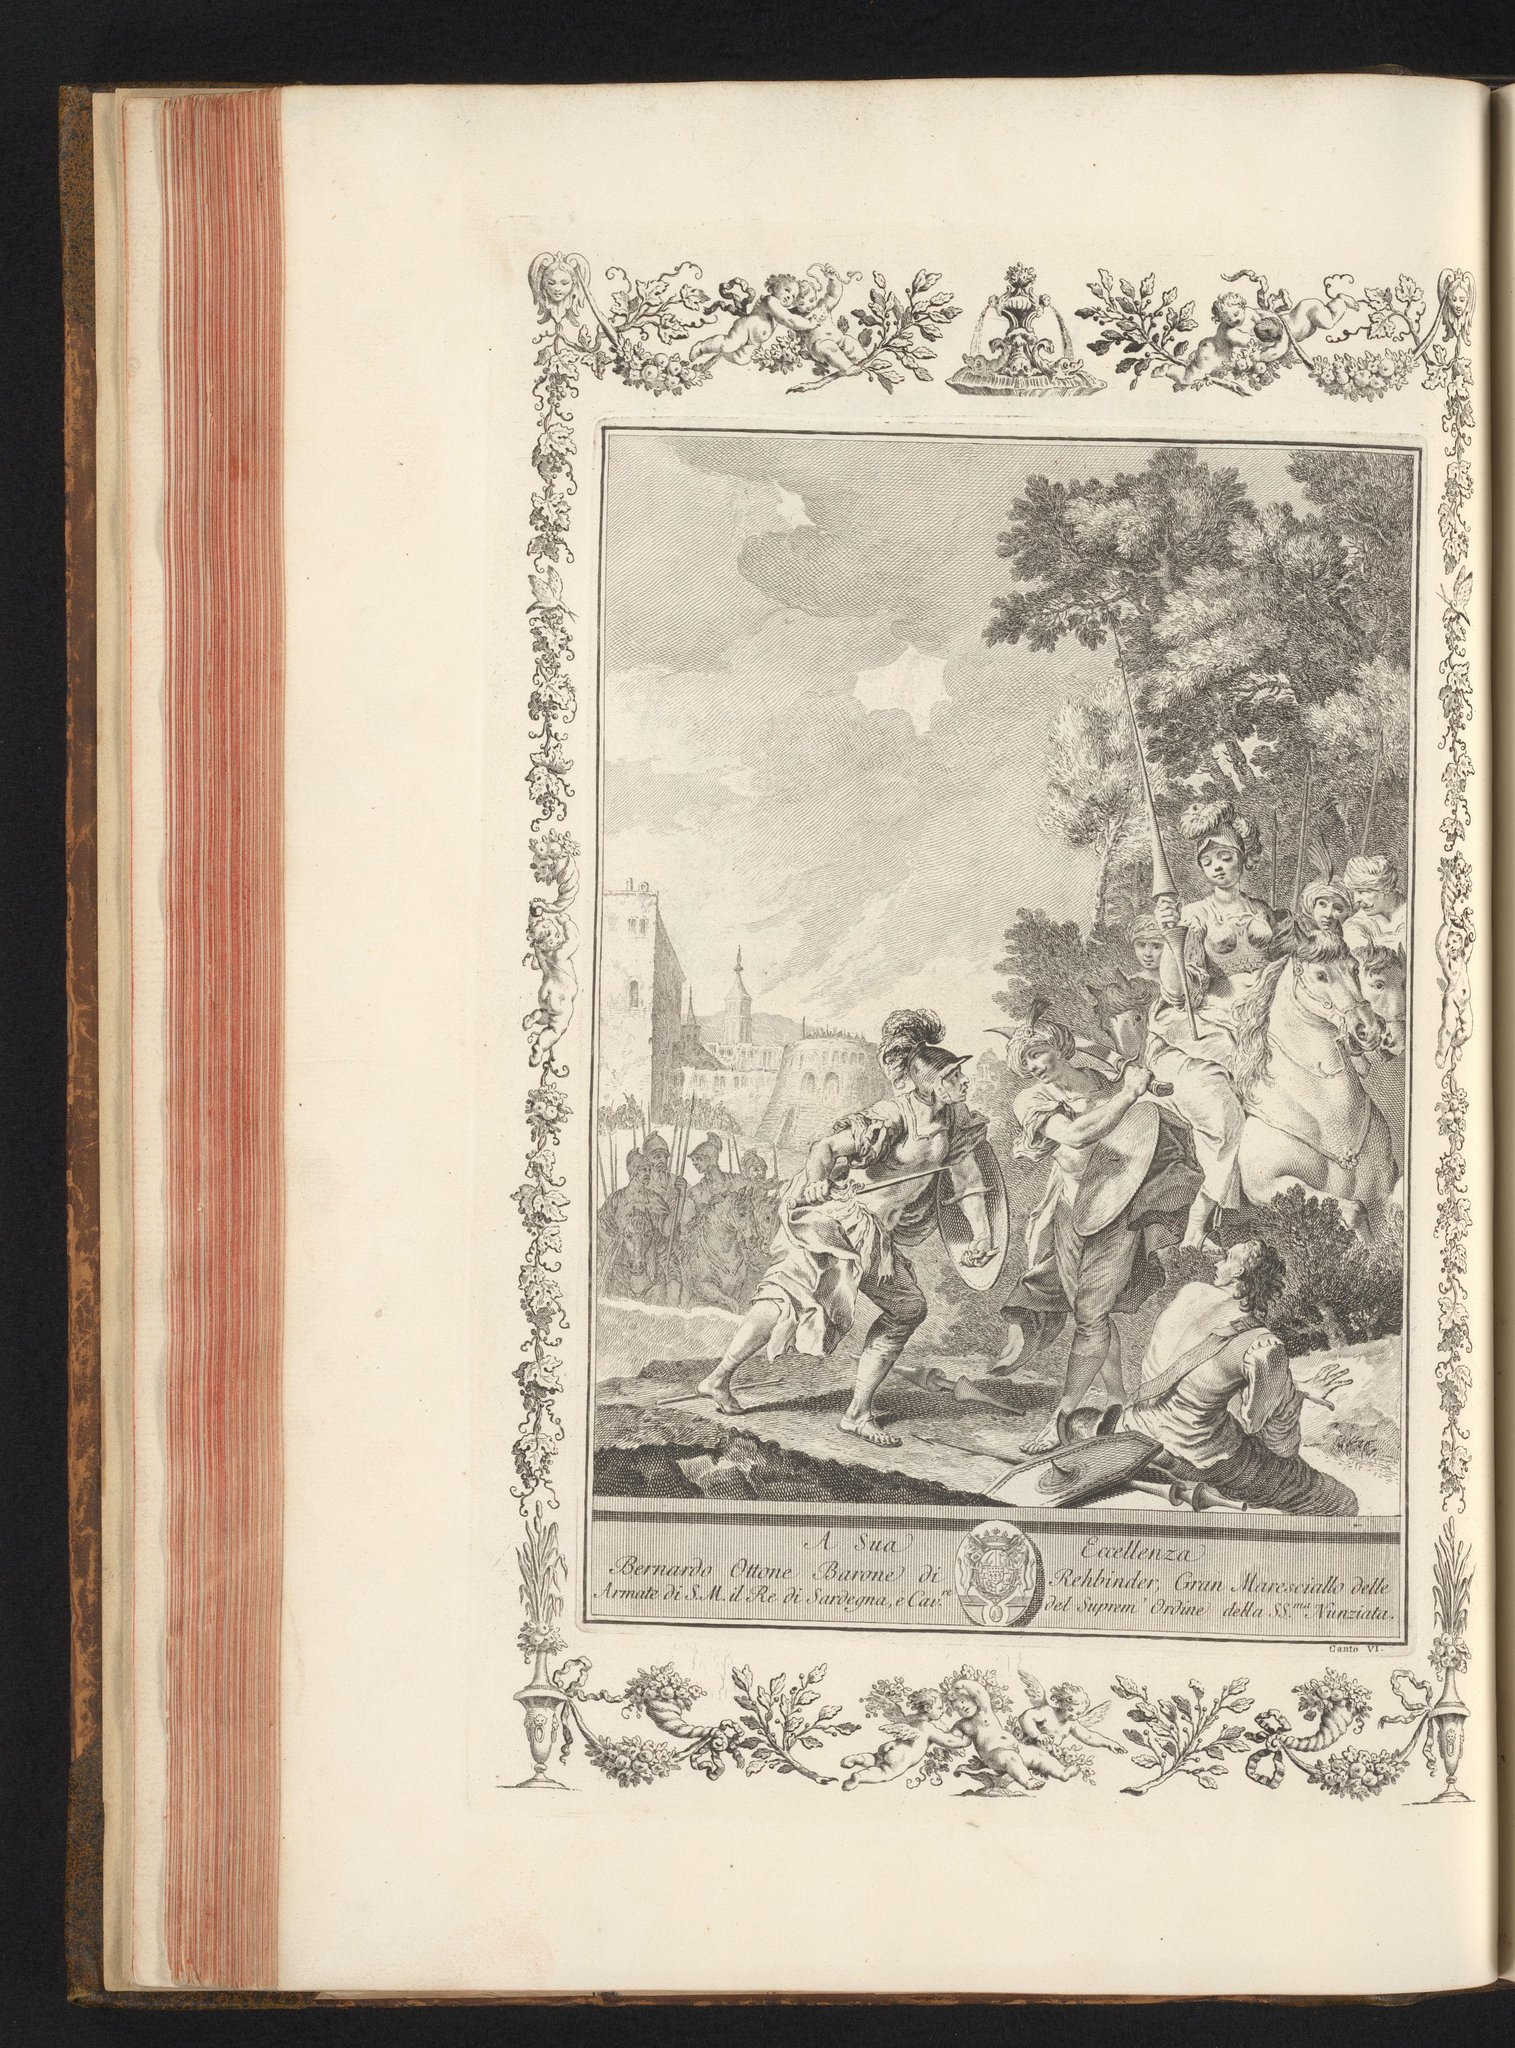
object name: book illustration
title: Zwaardgevecht met toeschouwers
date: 1745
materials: paper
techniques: etching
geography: venice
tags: land forces, hacking and thrusting weapons: sword, hand-to-hand fighting (~ battle), (scenes from) specific works of literature: tasso, gerusalemme liberata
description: Prent uit: Tasso, Torquato. La Gerusalemme liberata di Torquato Tasso con le figure de Giambatista Piazzetta. Venetië: Giambatista Albrizzi, 1745.